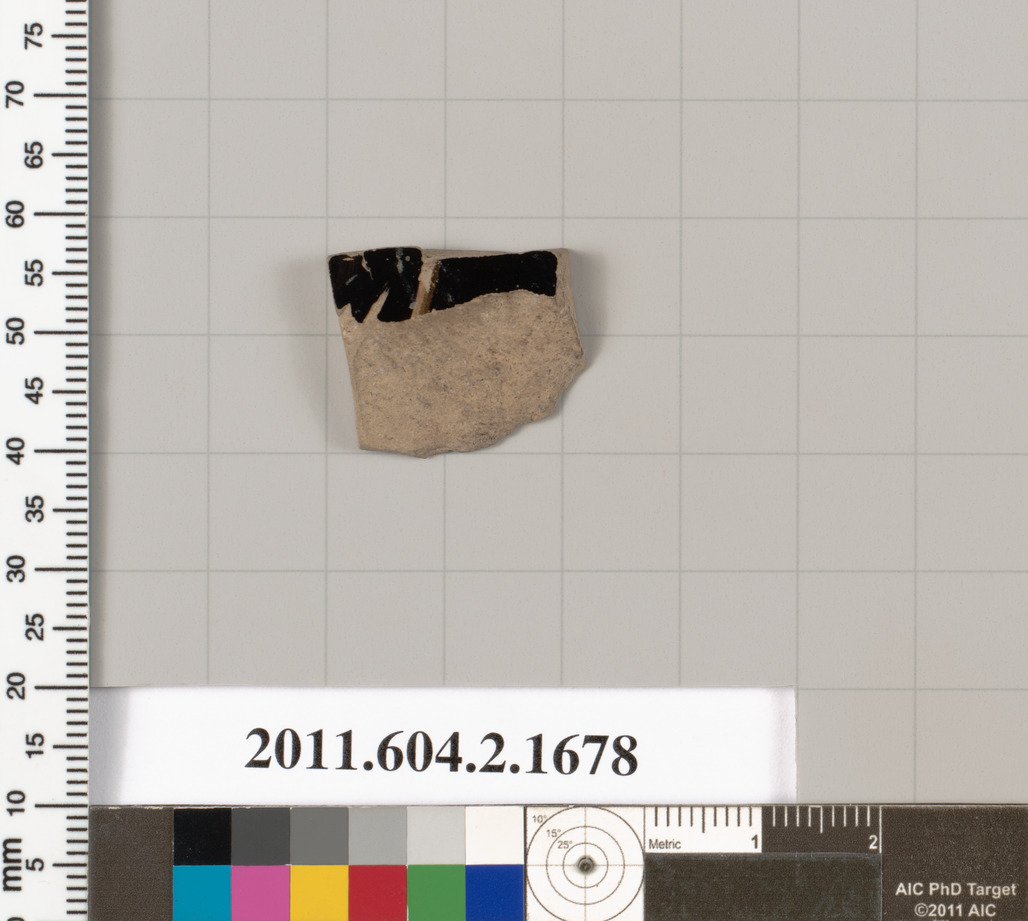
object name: skyphos fragment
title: Terracotta fragment of a skyphos (deep drinking cup)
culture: greek, attic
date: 450-401 BCE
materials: terracotta